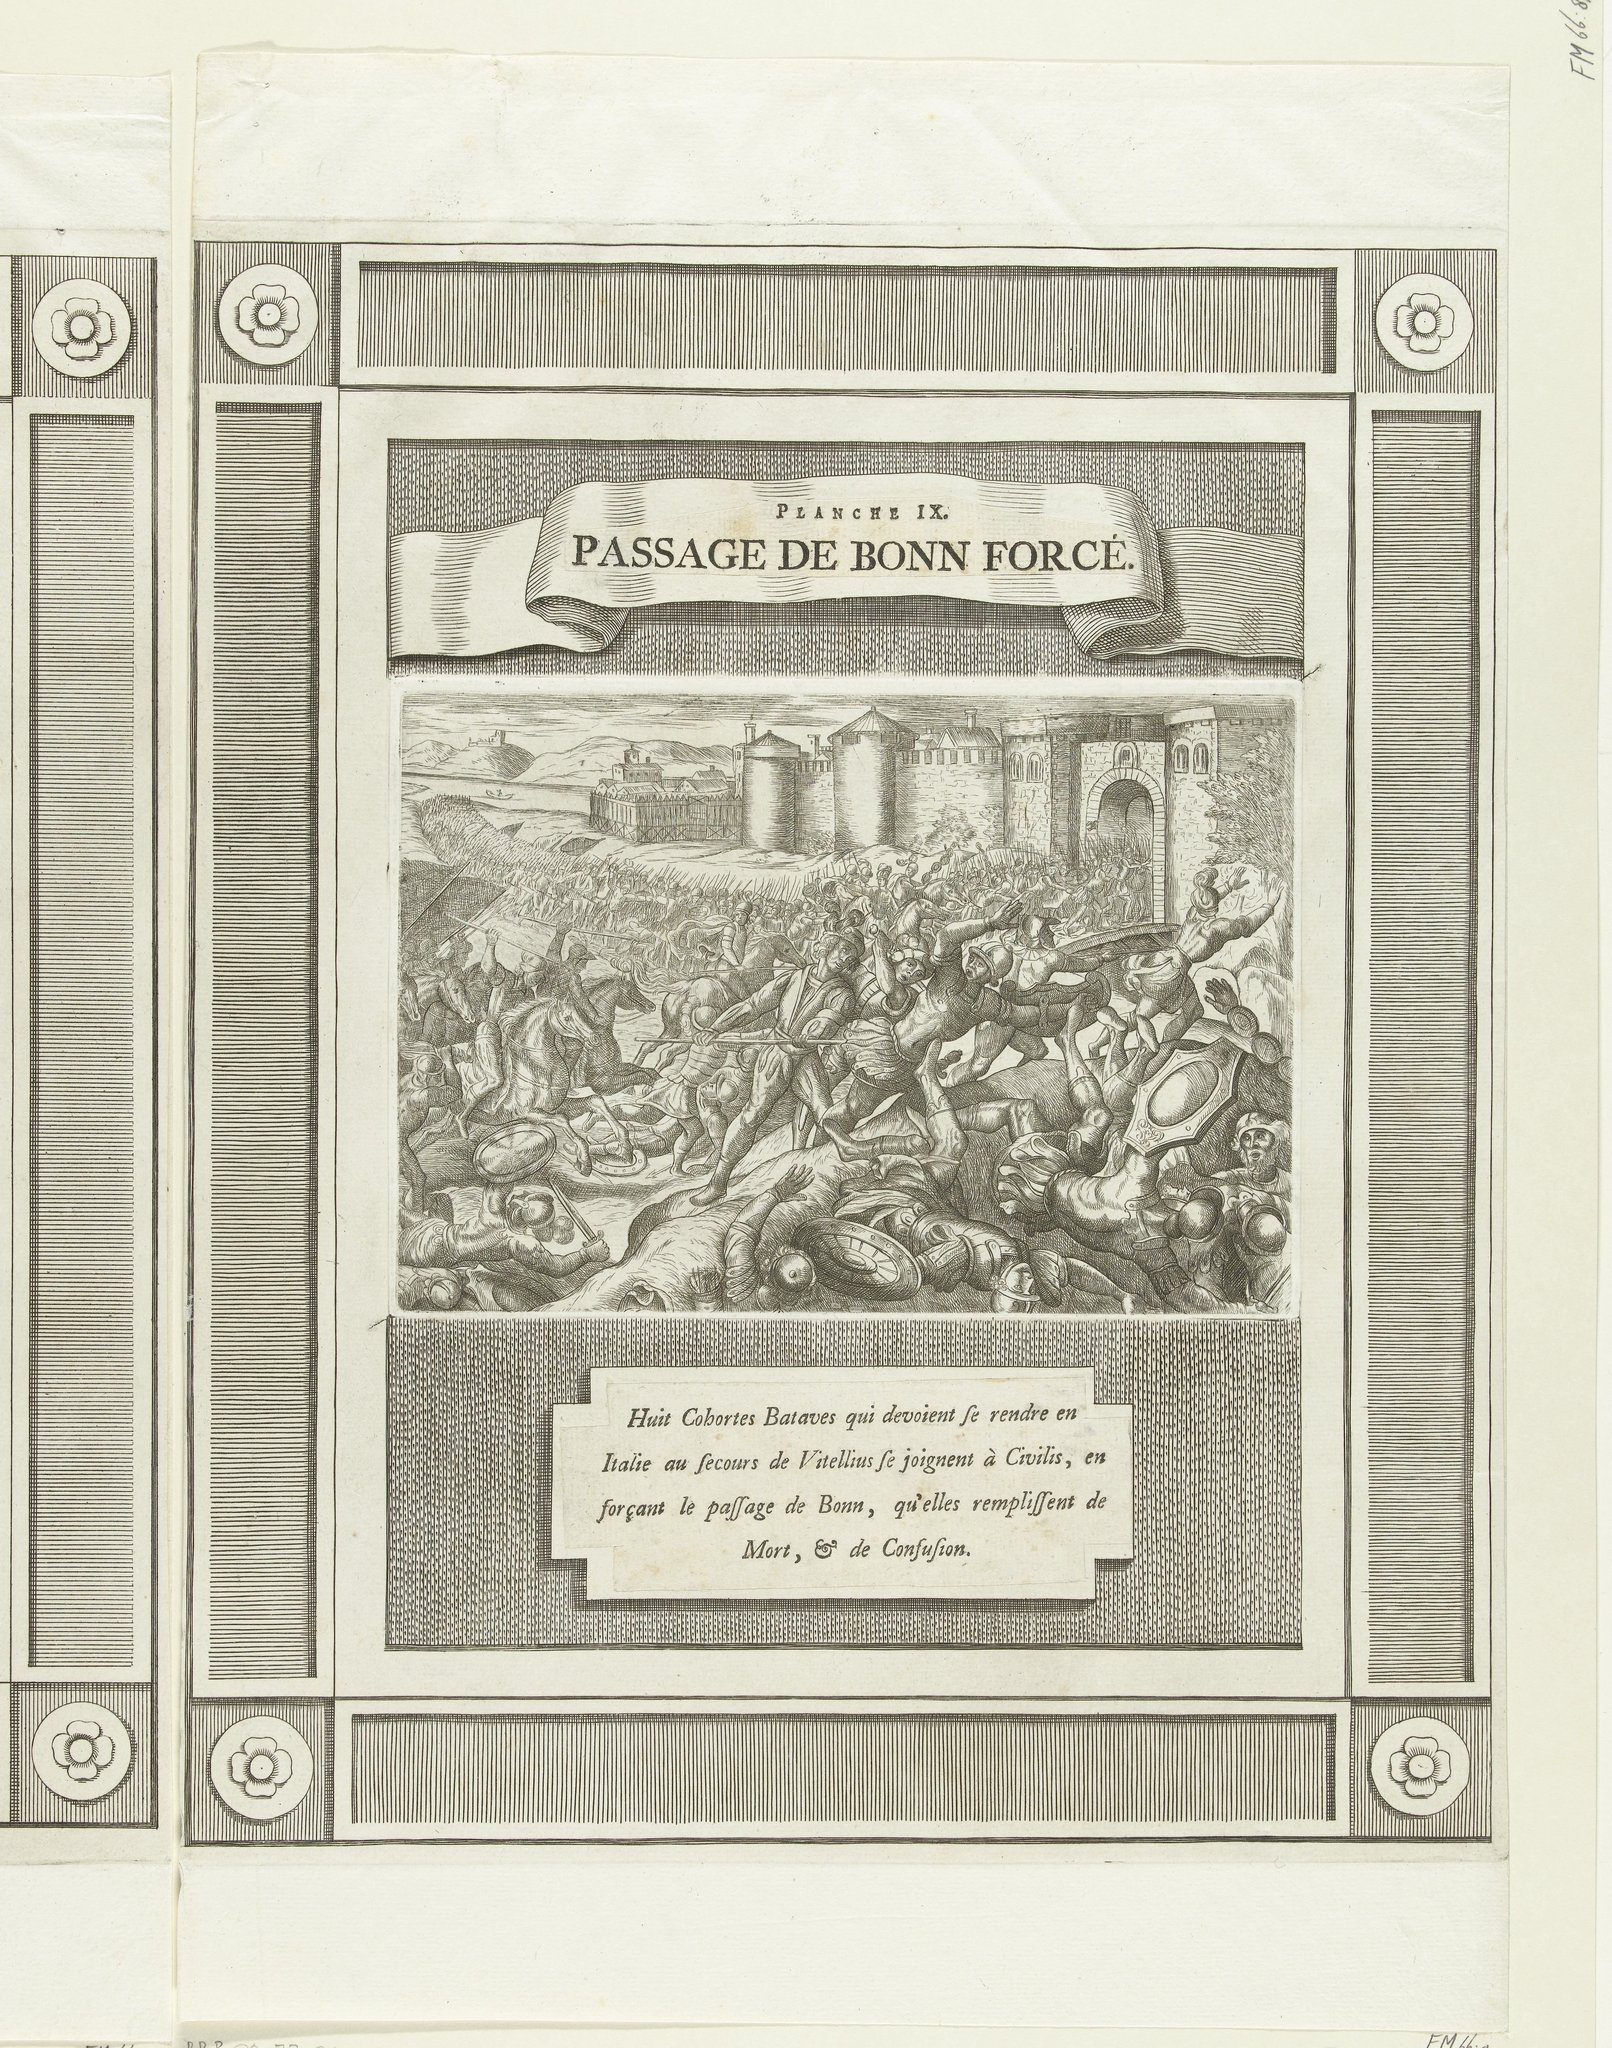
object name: history print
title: Kopieën naar Tempesta's Bataafse Opstand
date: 1768-1770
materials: paper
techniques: engraving, etching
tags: battle, fighting in general, extinct, 'historical' peoples (with name)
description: Duitsers komen om Civilis te helpen bij Bonn de Romeinen te verslaan. Prent 9 in een serie over de Bataafse Opstand, gekopieerd naar de reeks Batavorum cum Romanis bellum van Antonio Tempesta (Otto Vaenius, Antwerpen 1612). Illustratie voor: Marquis de St. Simon, Histoire de la guerre des Bataves et des Romains, d'après César; Corneille Tacite, Aux dépens de Marc-Michel Rey, Amsterdam 1770. Voorstellingen gedrukt in een grote ornamentele omlijsting waarin bovenaan een uitgeknipte titel en onderaan een onderschrift in het Frans is geplakt.